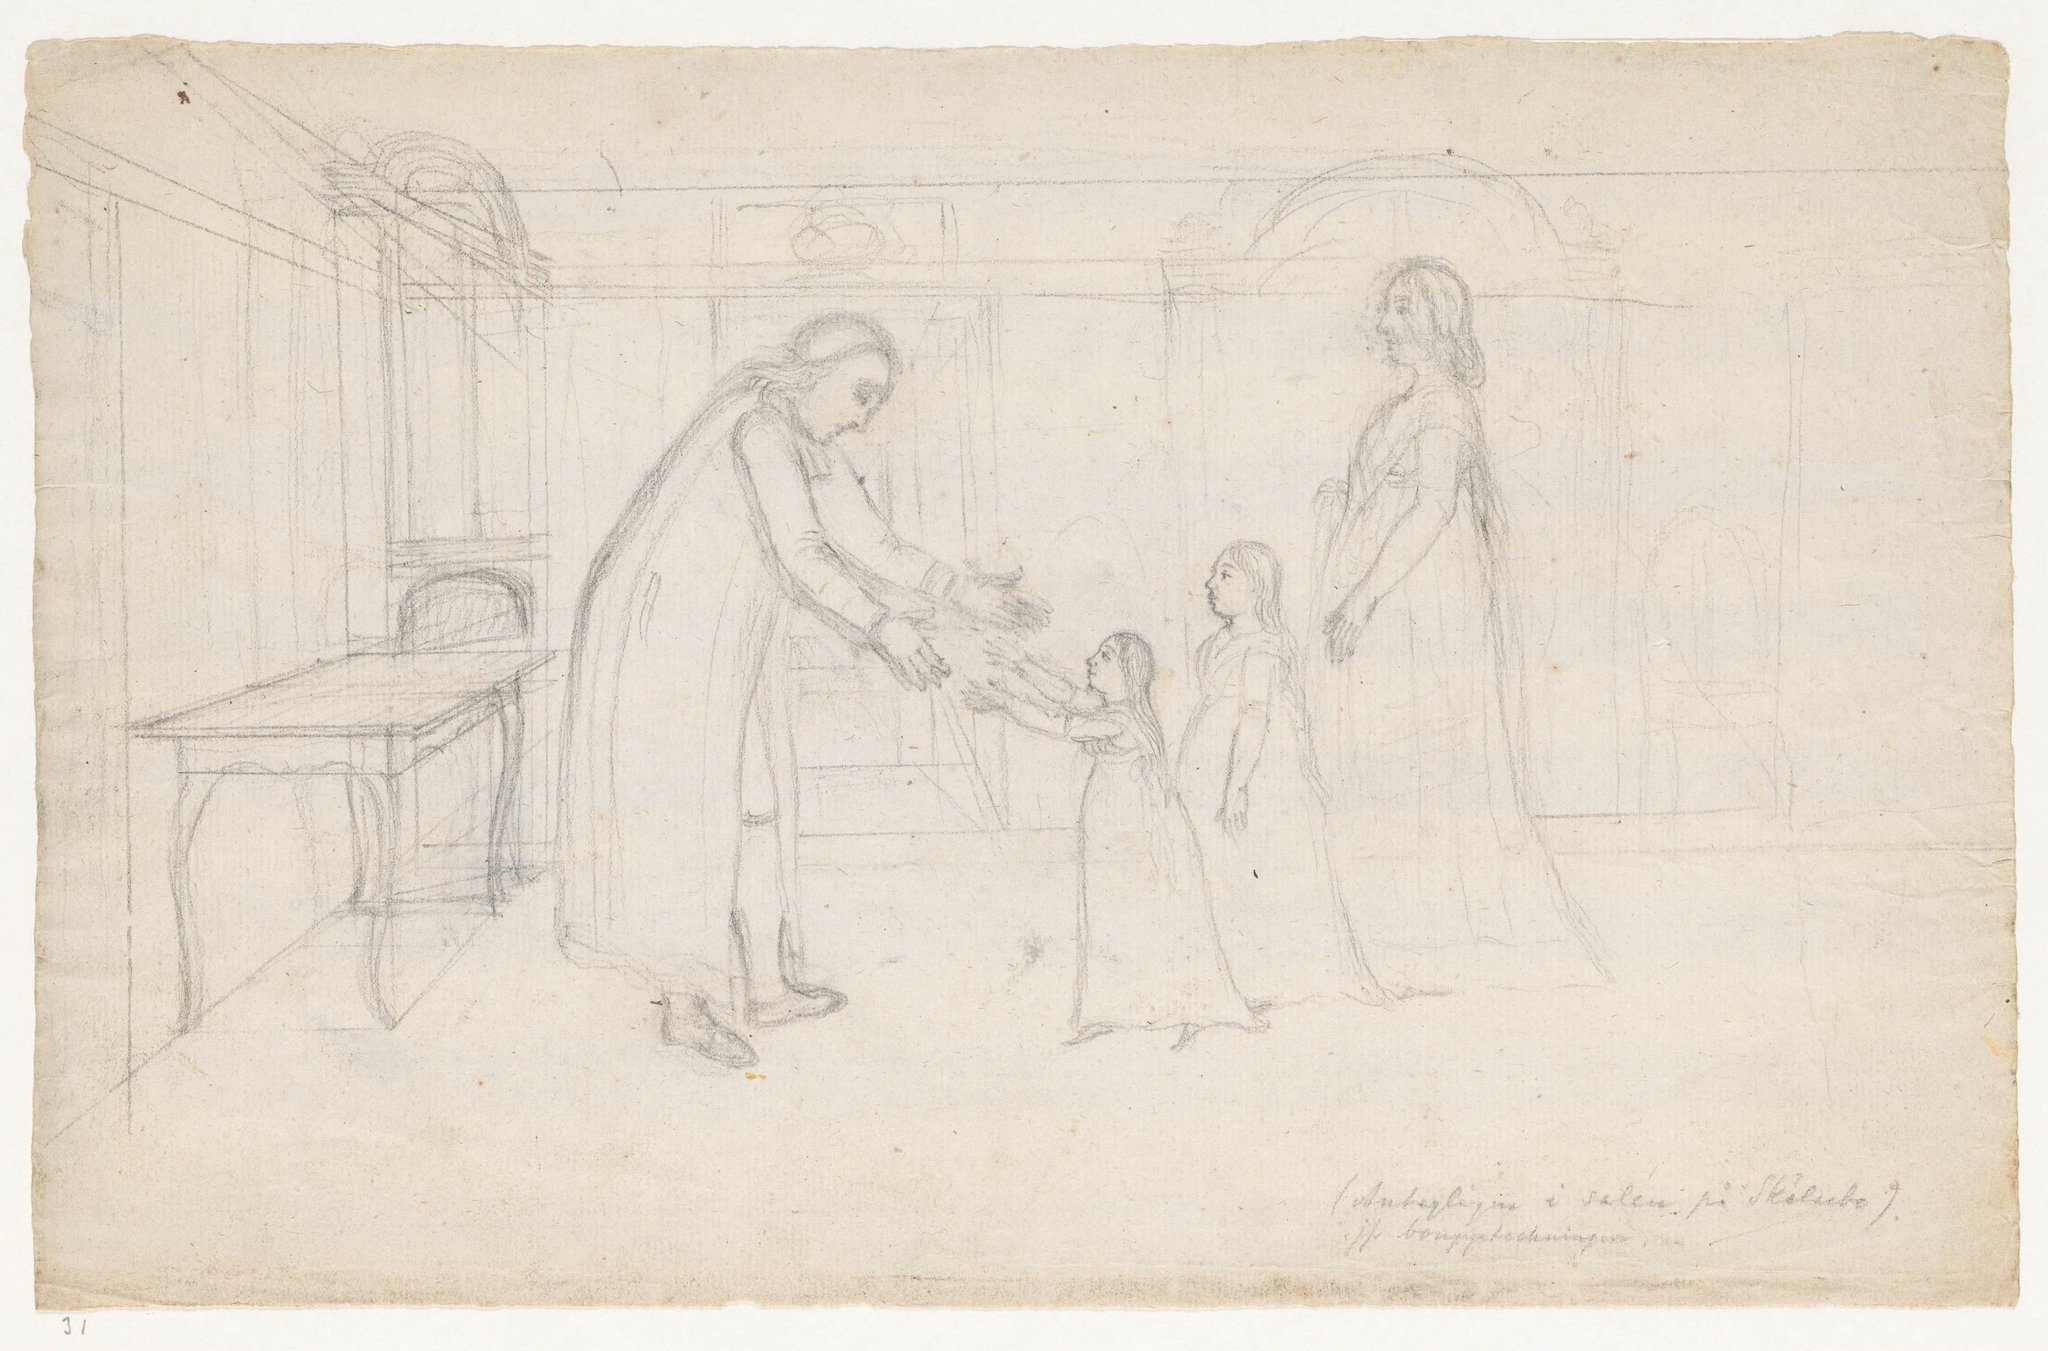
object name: drawing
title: Gezin van Jan Brandes te Skalsebö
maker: jan brandes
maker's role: draughtsman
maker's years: 1743-1808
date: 1788-1808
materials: paper, pencil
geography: skälsebo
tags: bodegraven, draughtsman, jan brandes, family life at home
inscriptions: inscription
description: Jan Brandes begroet zijn twee dochters en zijn vrouw in de salon van hun huis te Skalsebö.